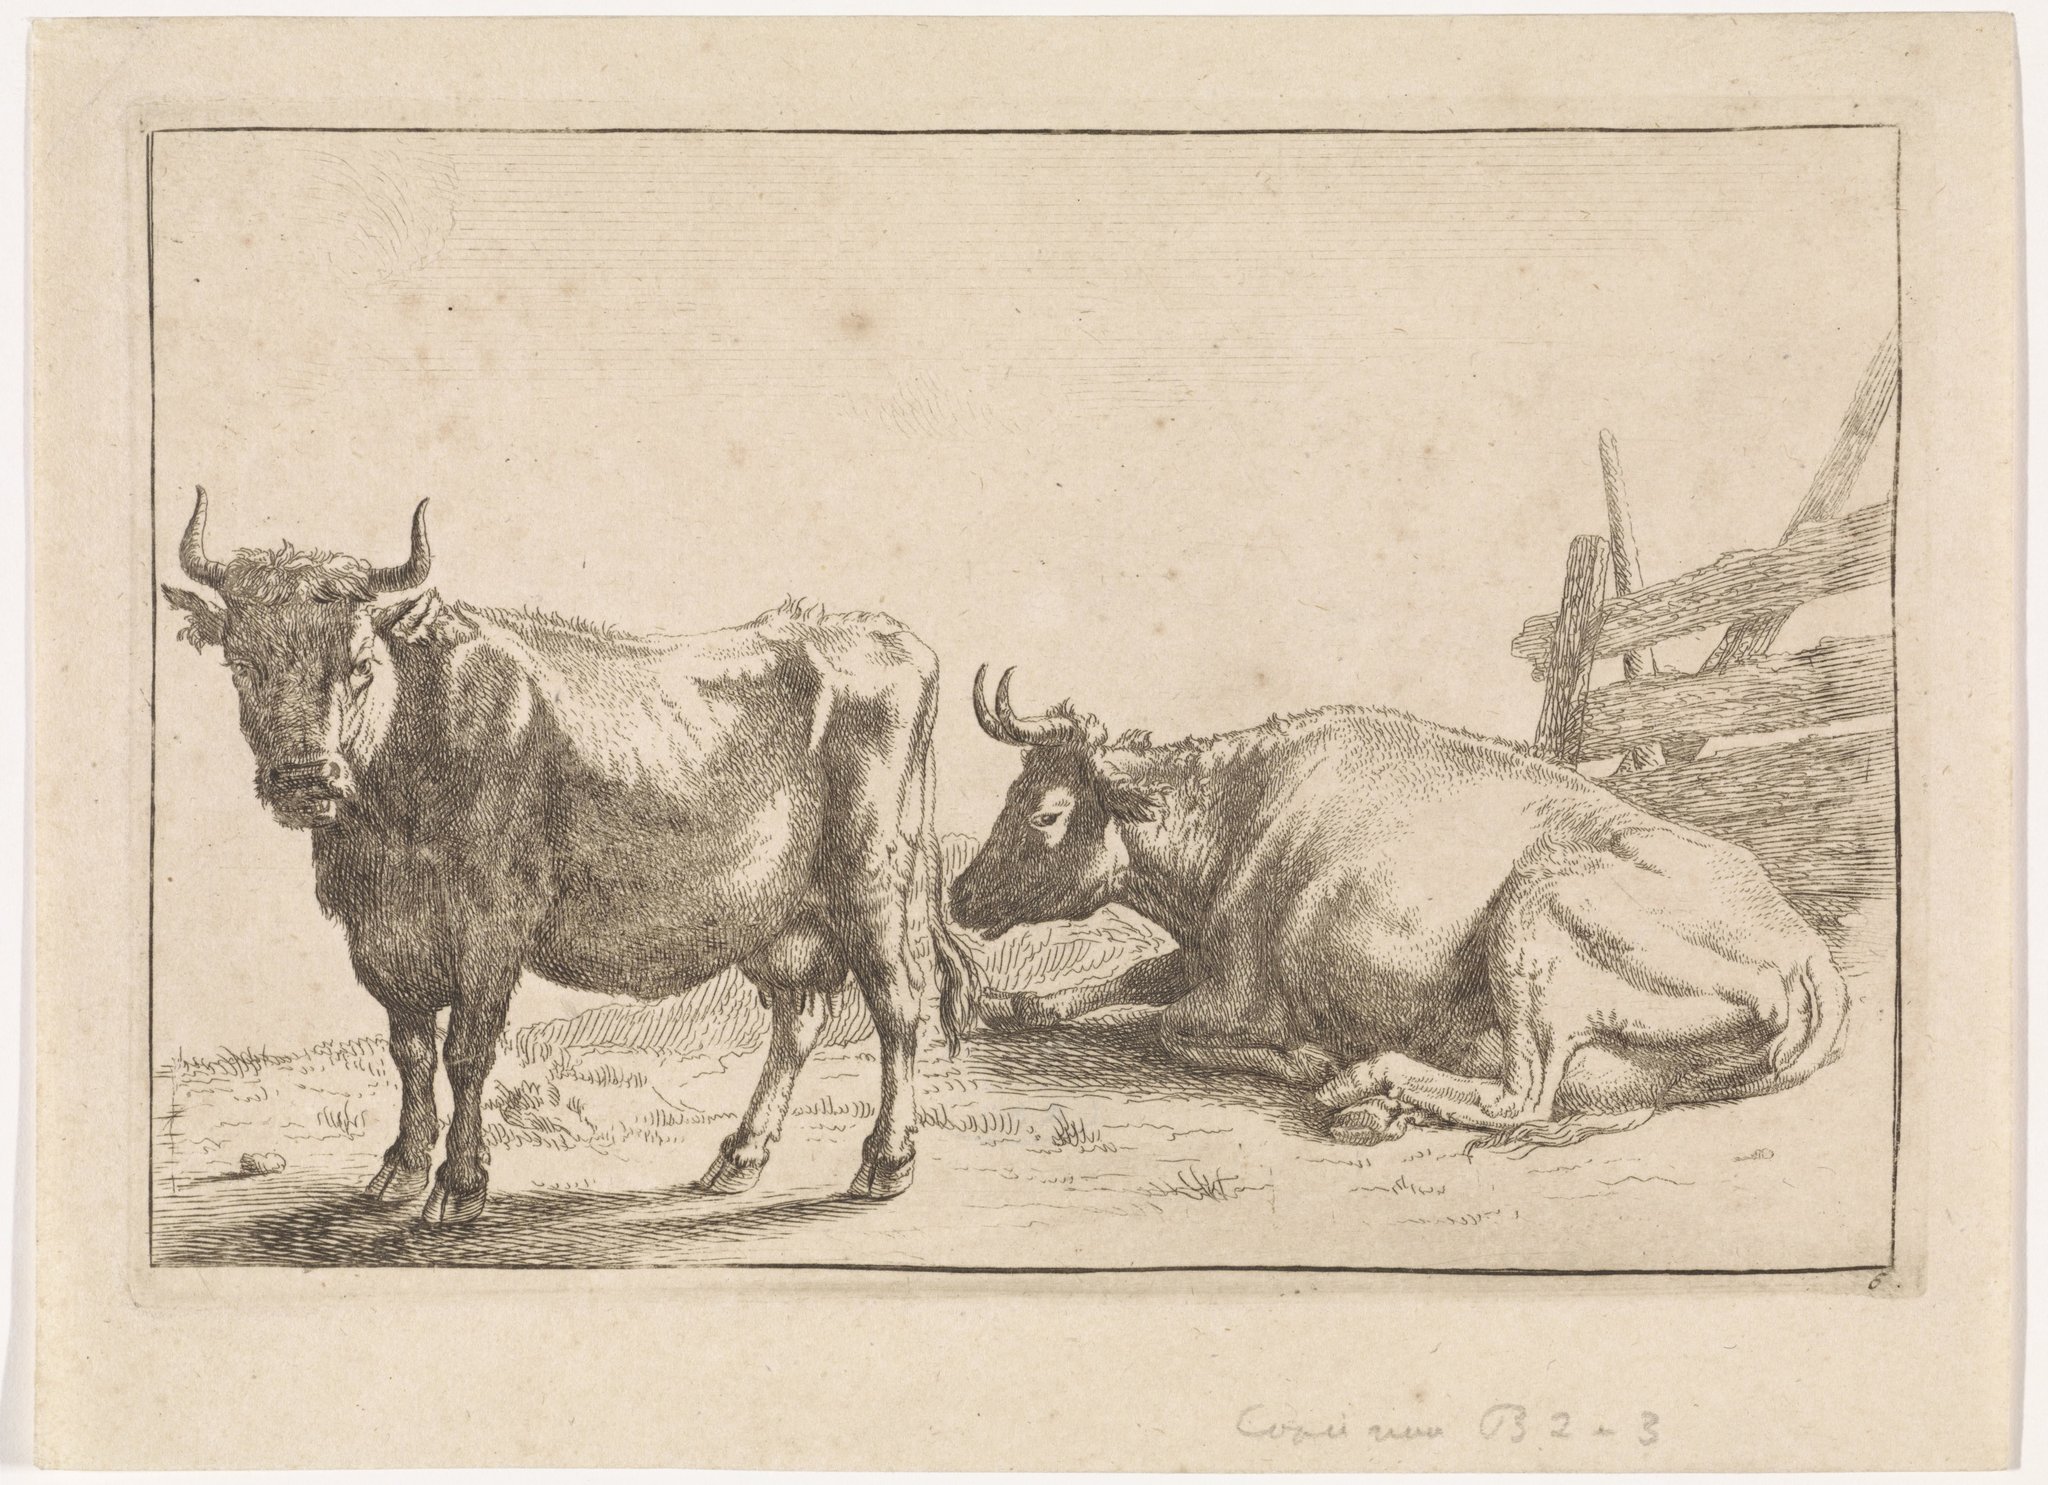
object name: print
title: Een staande en een liggende koe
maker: Anonymous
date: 1635-1704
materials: paper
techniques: engraving, etching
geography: netherlands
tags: cow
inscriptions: collector's mark: Lugt 2228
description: Deze kopie is opgebouwd uit verschillende elementen van prenten uit de serie Het Bullenboekje van Paulus Potter. Respectievelijk, de staande koe, in spiegelbeeld, uit Een staande en een liggende koe en de liggende koe, in dezelfde richting, uit Liggende koe bij een hek.